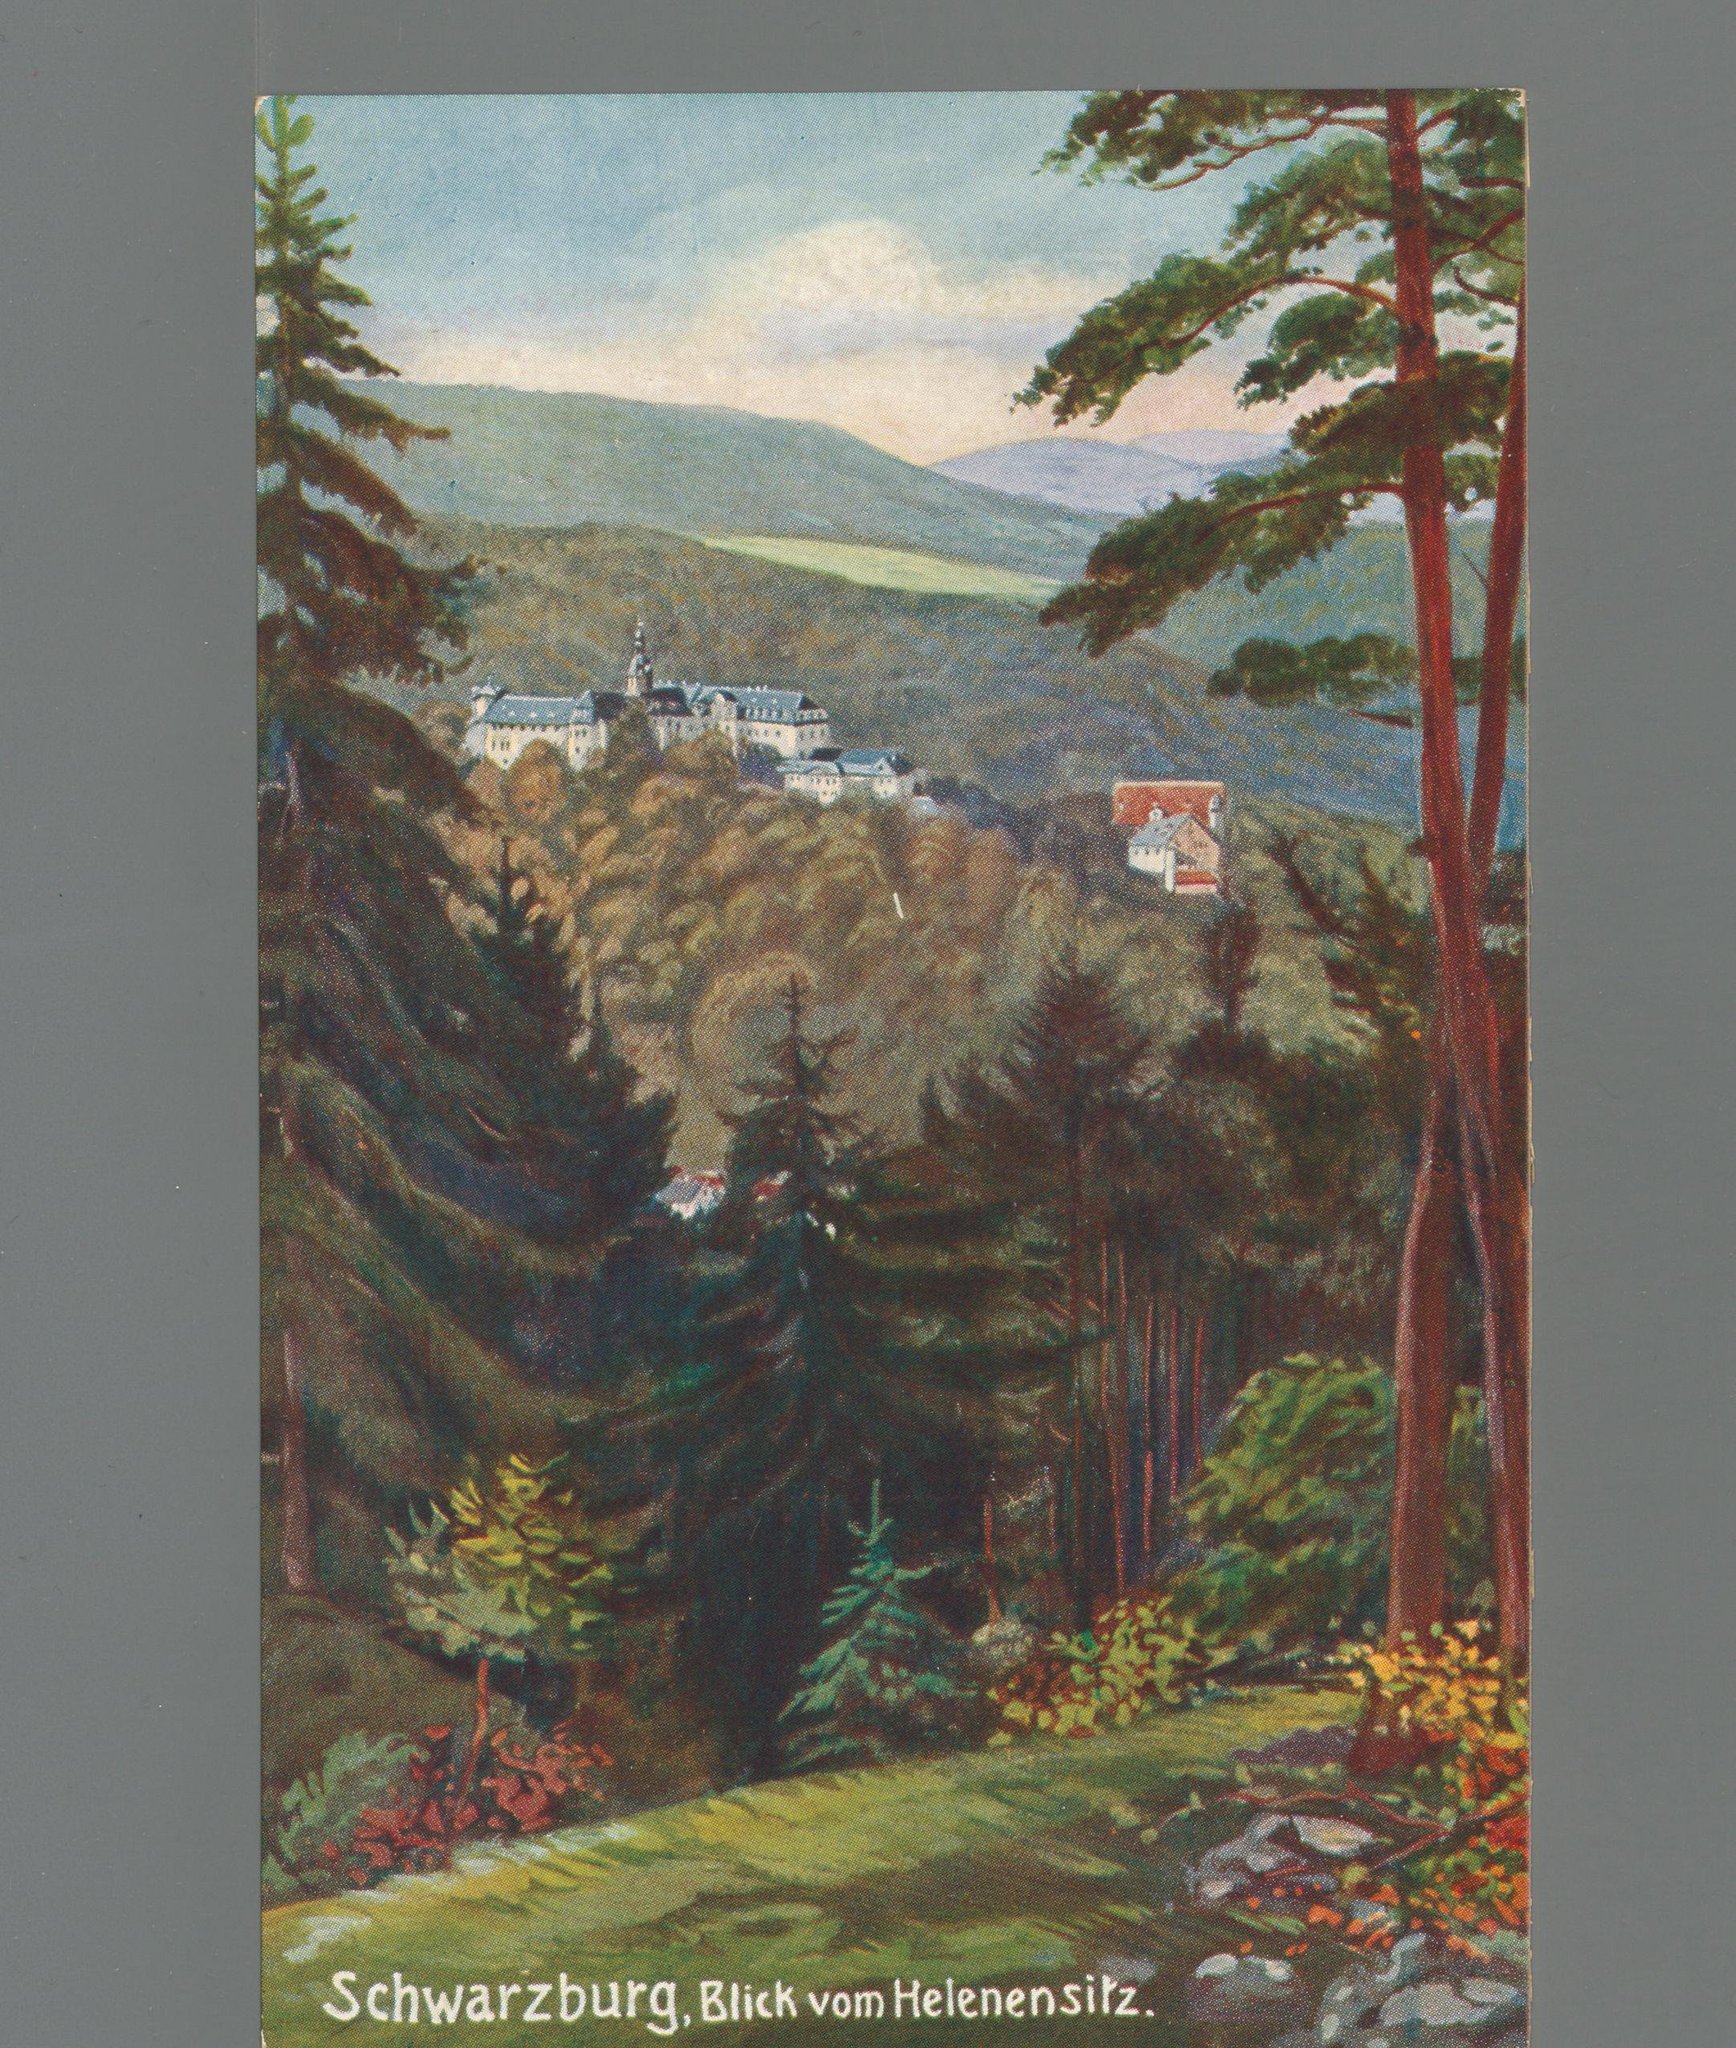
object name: photomechanical print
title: Schwarzburg, Blick vom Helenensitz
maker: karl thomass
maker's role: lithograaf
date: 1905-1930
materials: cardboard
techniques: color autotype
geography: gehren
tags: castle, mountains